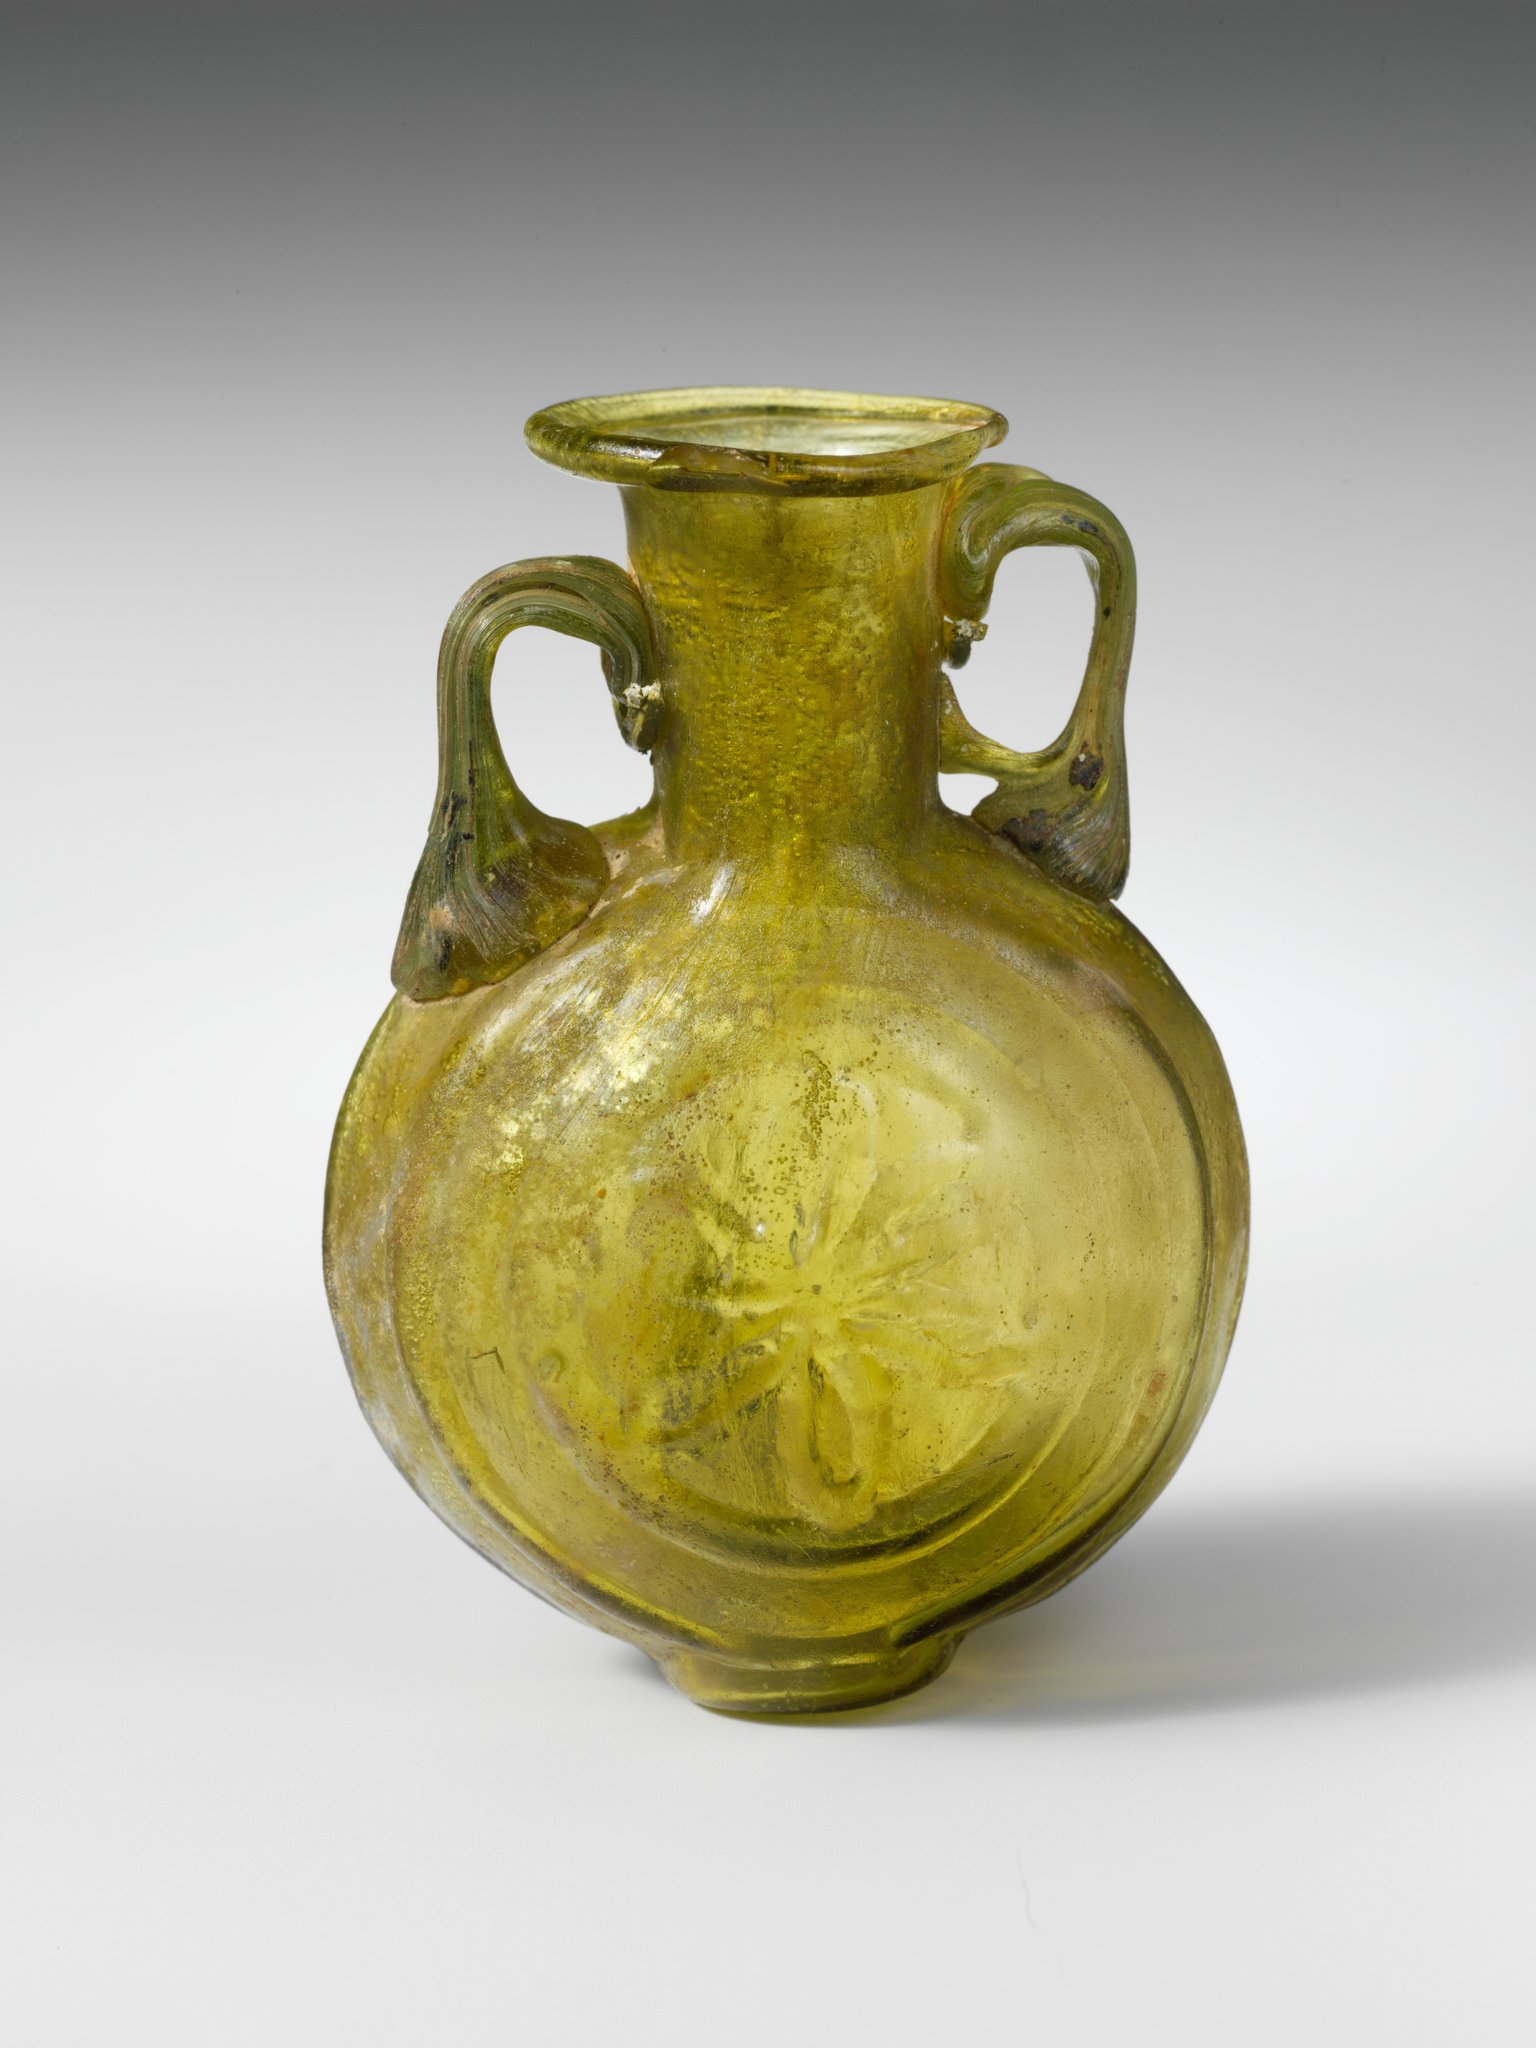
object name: amphoriskos, lentoid with rosette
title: Glass lentoid amphoriskos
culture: roman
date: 1-100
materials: glass